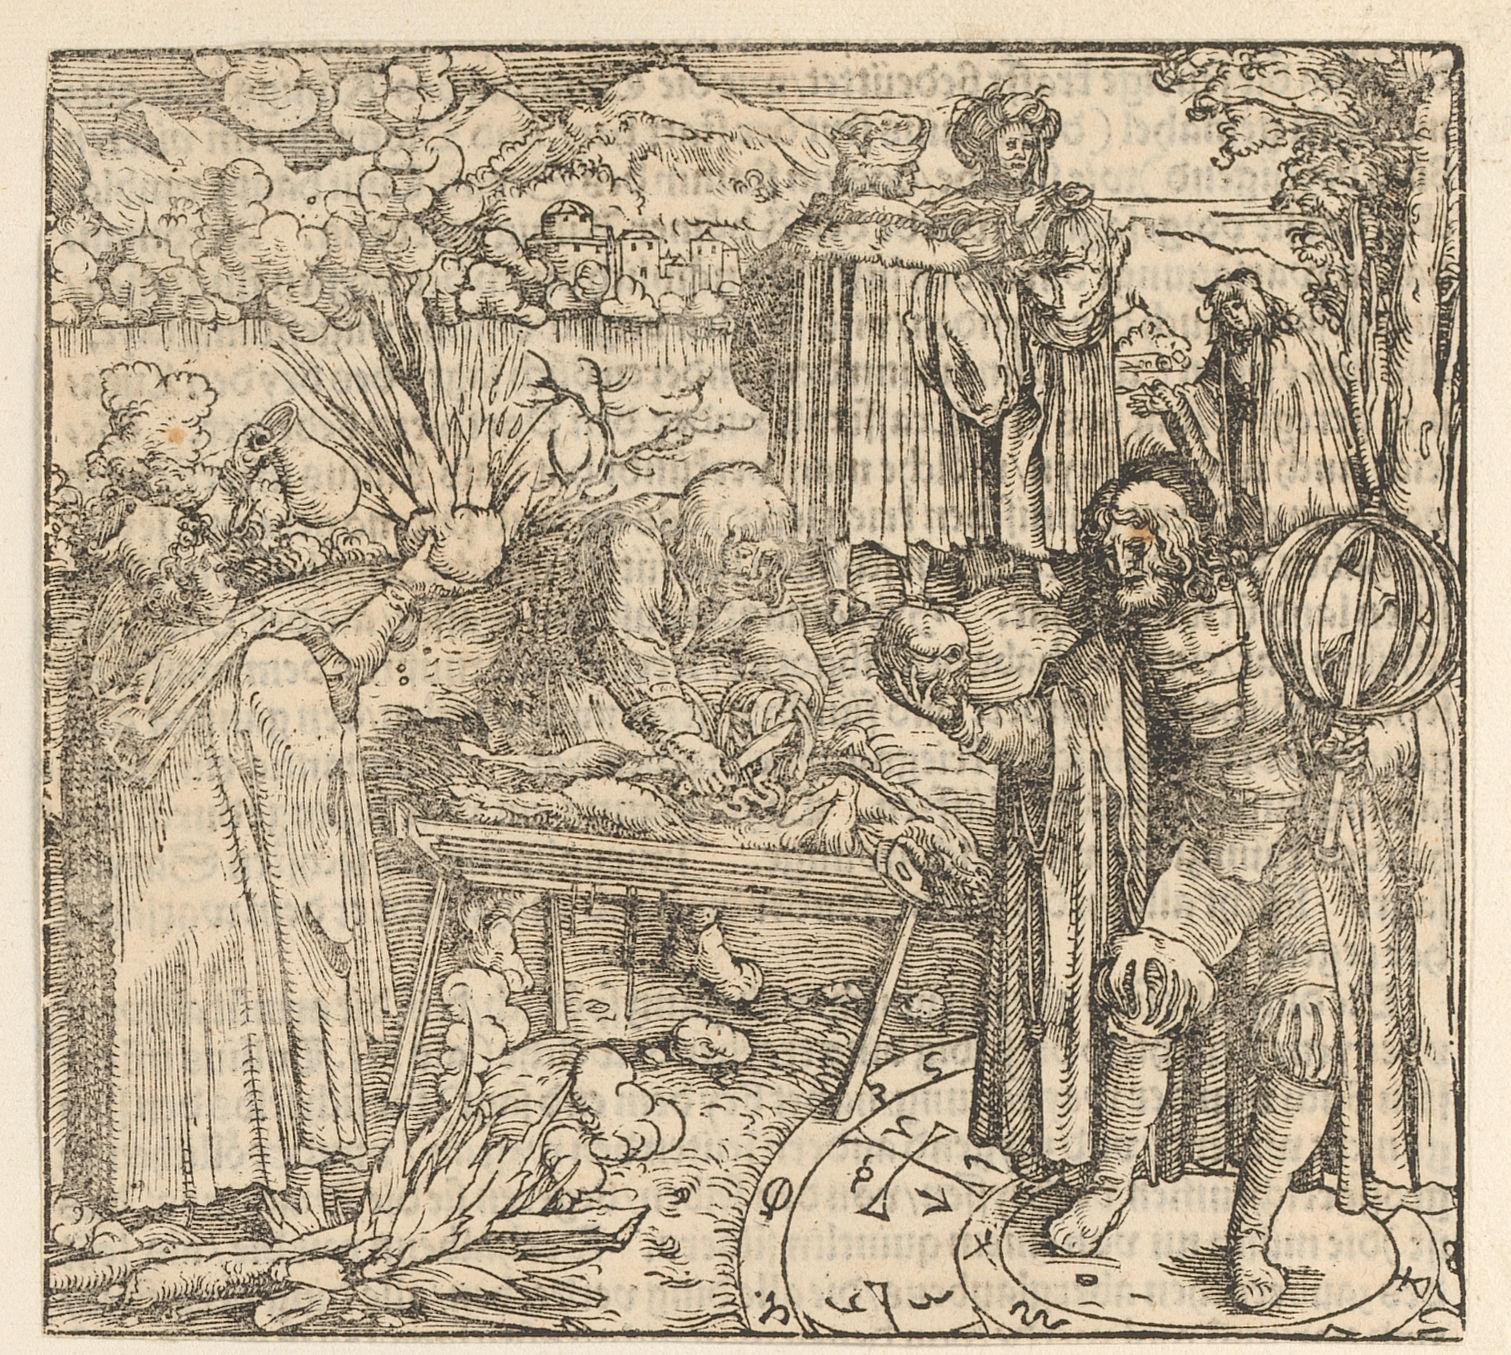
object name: book illustration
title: Ziener, schouwer en alchemist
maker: Anonymous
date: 1514-1532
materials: paper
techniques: letterpress printing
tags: 'haruspex' ~ roman religion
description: Deze prent is gebruikt in: Petrarca, Francesco. Von der Artzney bayder Glück, des guten und widerwertigen: unnd weß sich ain yeder inn Gelück und Unglück halten sol (...). Augsburg: Heinrich Steiner, 1532. Deze uitgave is ook bekend onder de titel 'Trostspiegel in Glück und Unglück'.